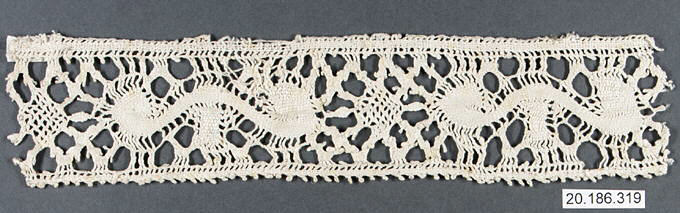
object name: insertion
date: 1701-1800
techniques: lace